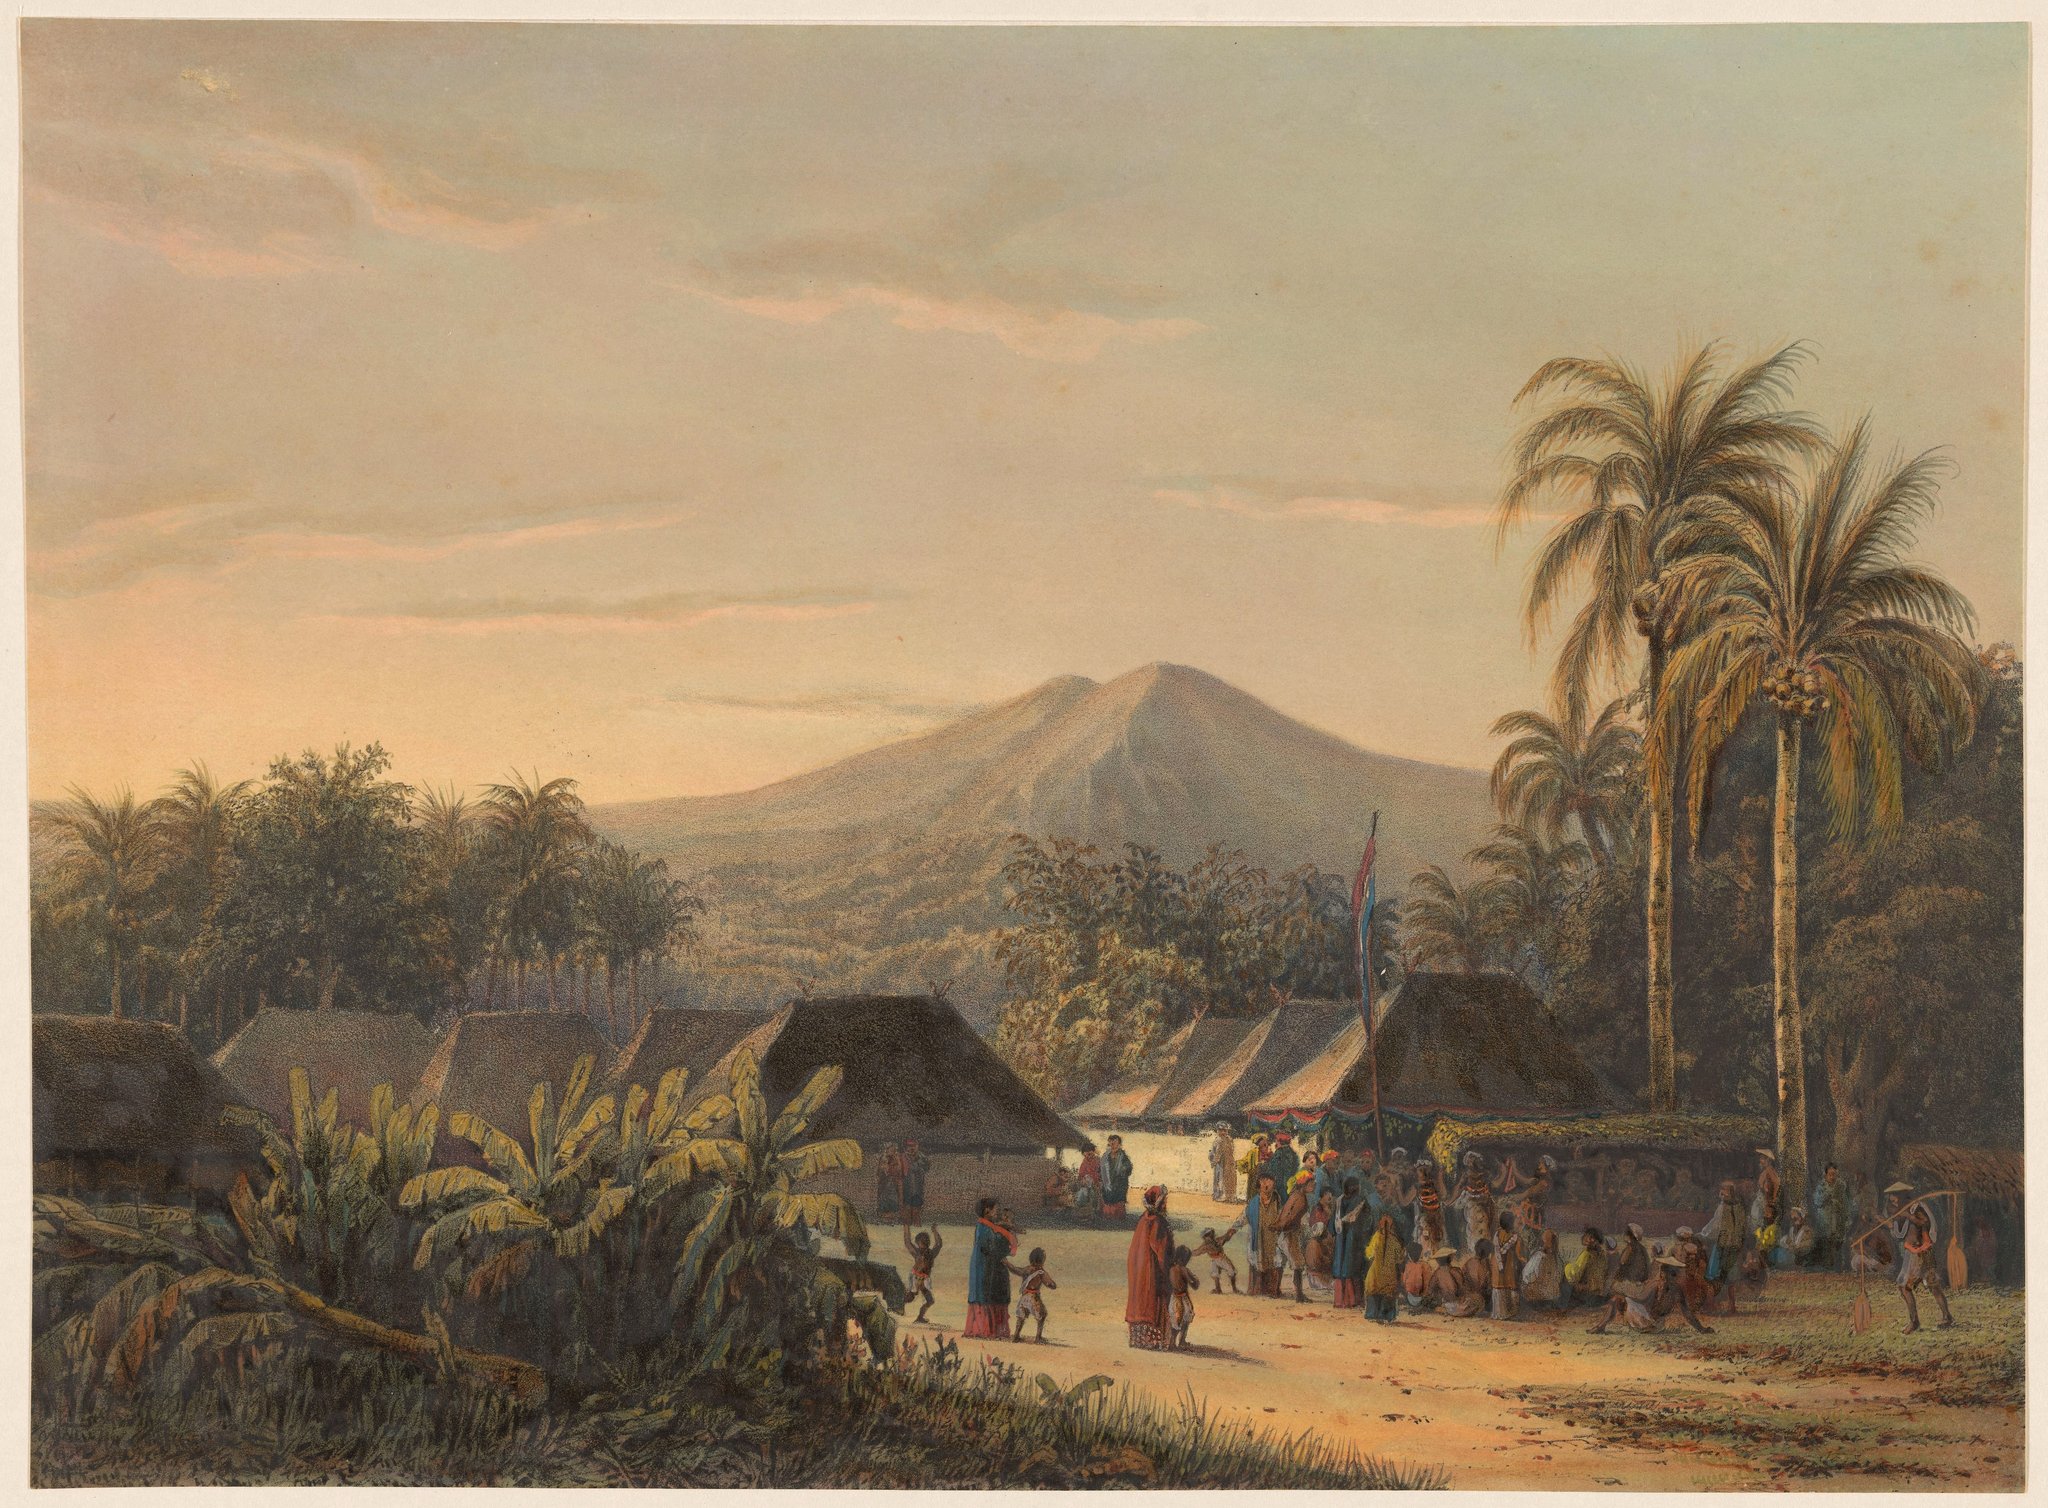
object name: print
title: Dorpsfeest in de omstreken der Ardjoeno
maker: johan conrad greive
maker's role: draughtsman, painter, print maker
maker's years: 1837-1891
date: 1869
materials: paper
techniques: lithograph, hand coloring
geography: amsterdam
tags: landscapes in tropical and sub-tropical regions, public festivities, java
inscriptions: collector's mark: Lugt 2228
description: De dorpsbewoners hebben zich verzameld bij een Nederlandse vlag. De prent maakt deel uit van een omslag met een tekstblad en 24 losse prenten.